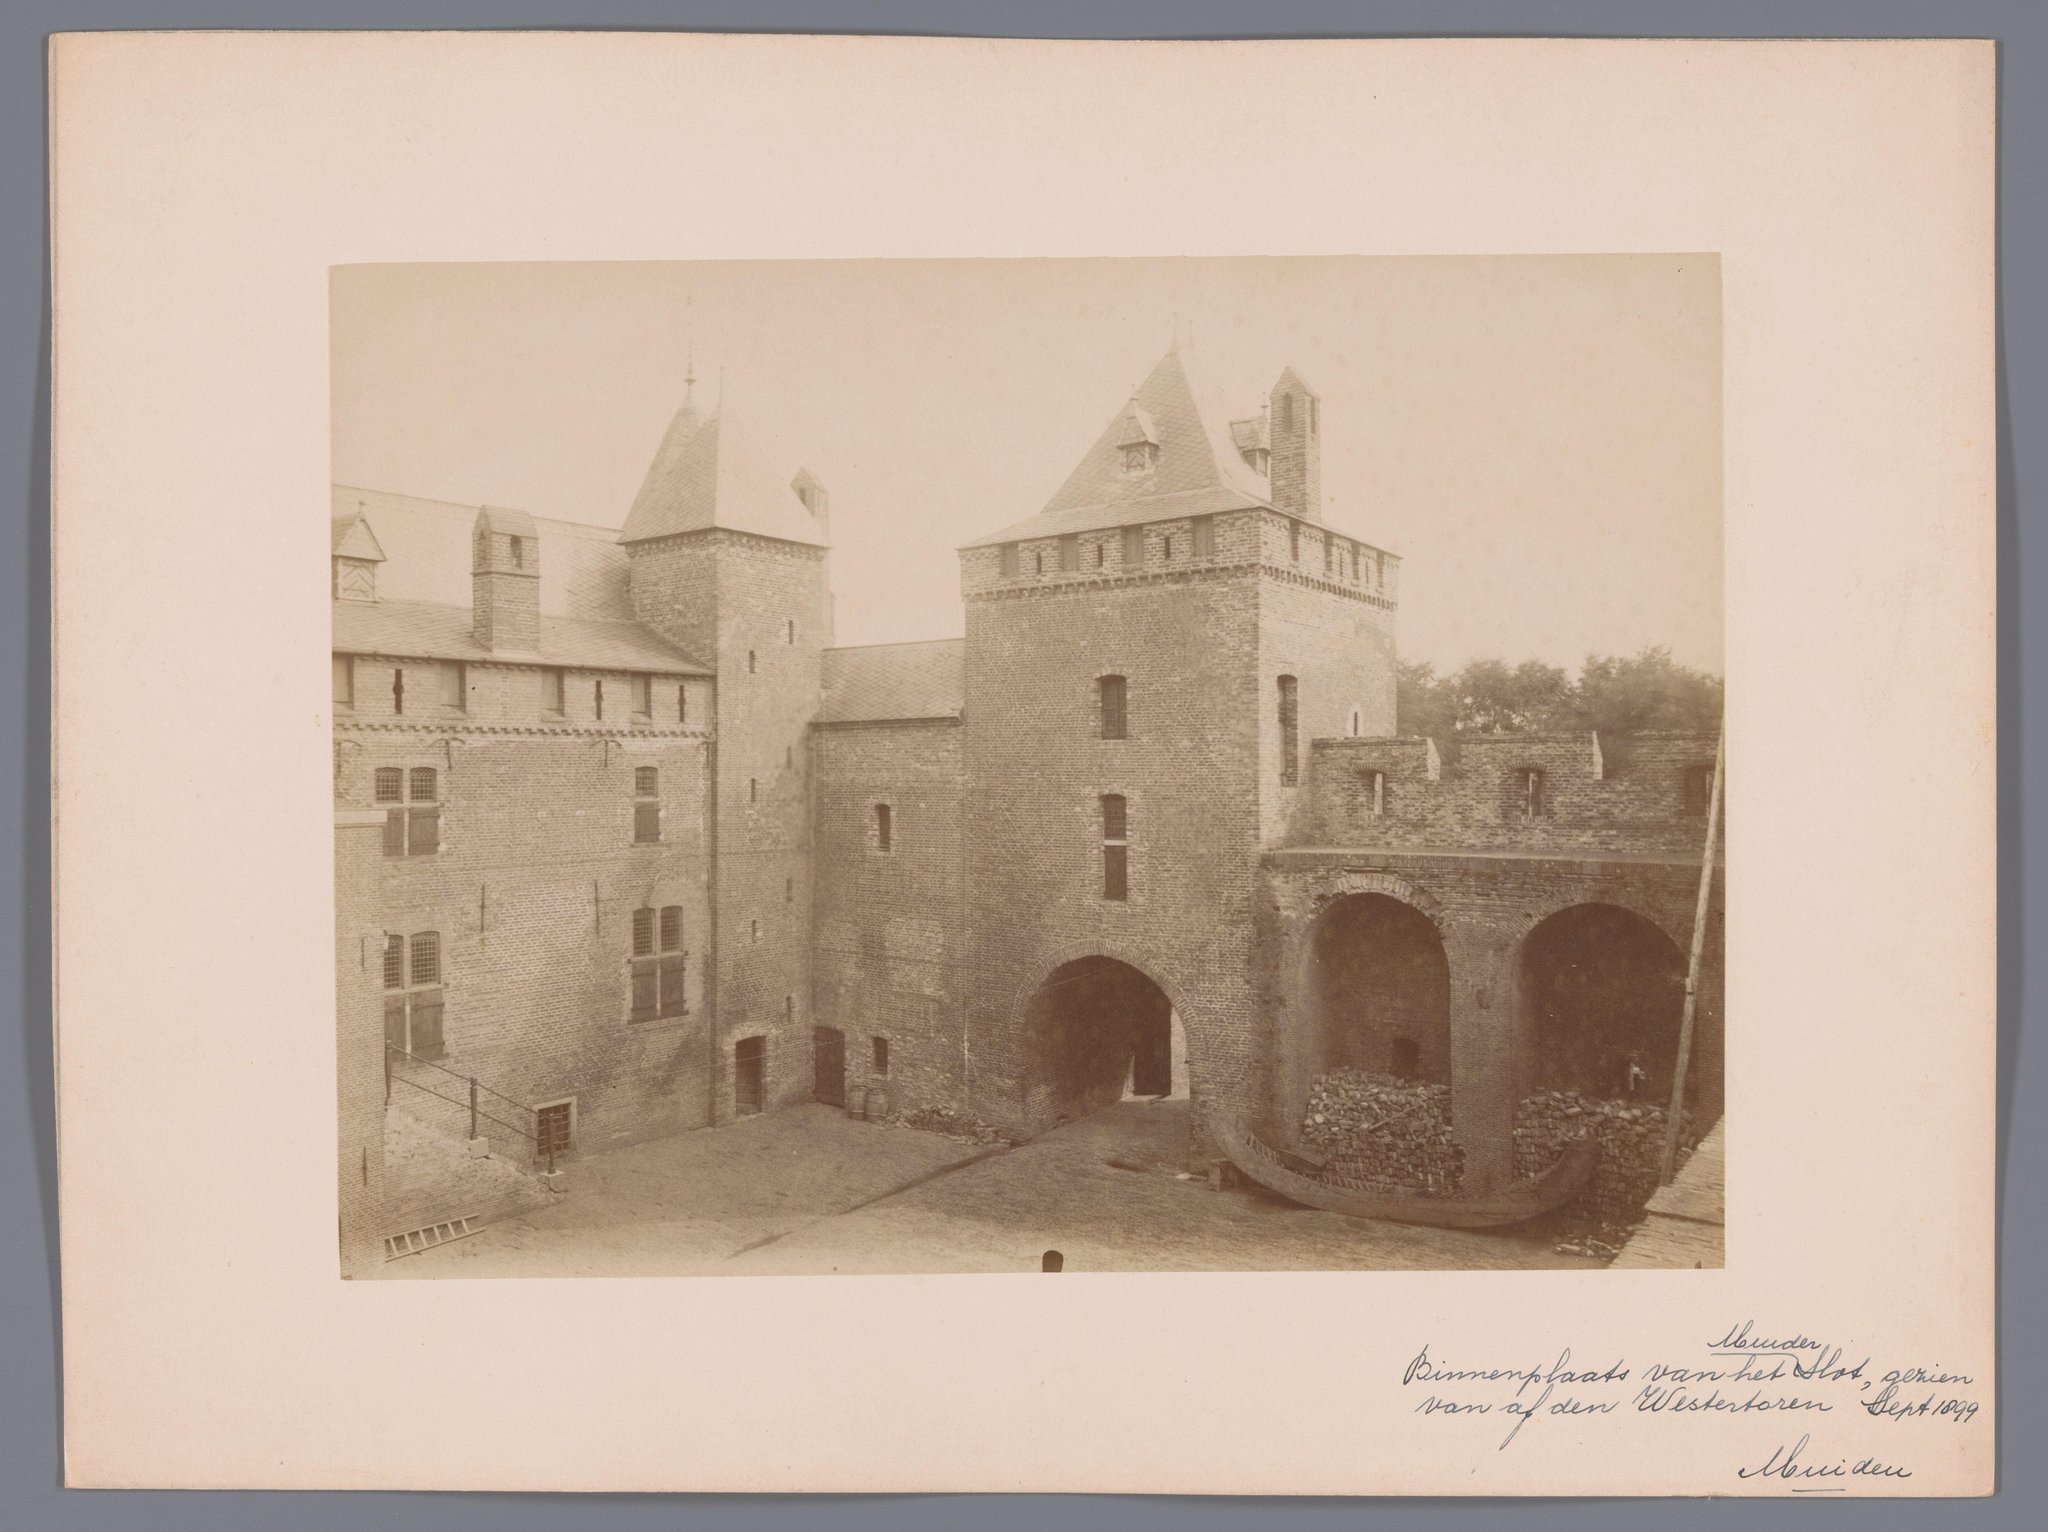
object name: photograph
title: Binnenplaats van het Muiderslot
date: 1899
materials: cardboard, photographic support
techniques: albumen print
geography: muiderslot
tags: castle, courtyard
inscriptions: annotation: ‘Binnenplaats van het slot te Muiden (N.H.) gezien van af den Westertoren sept 1899’, annotation: ‘Binnenplaats van het Muiderslot, gezien van af den Westertoren Sept 1899/ Muiden’